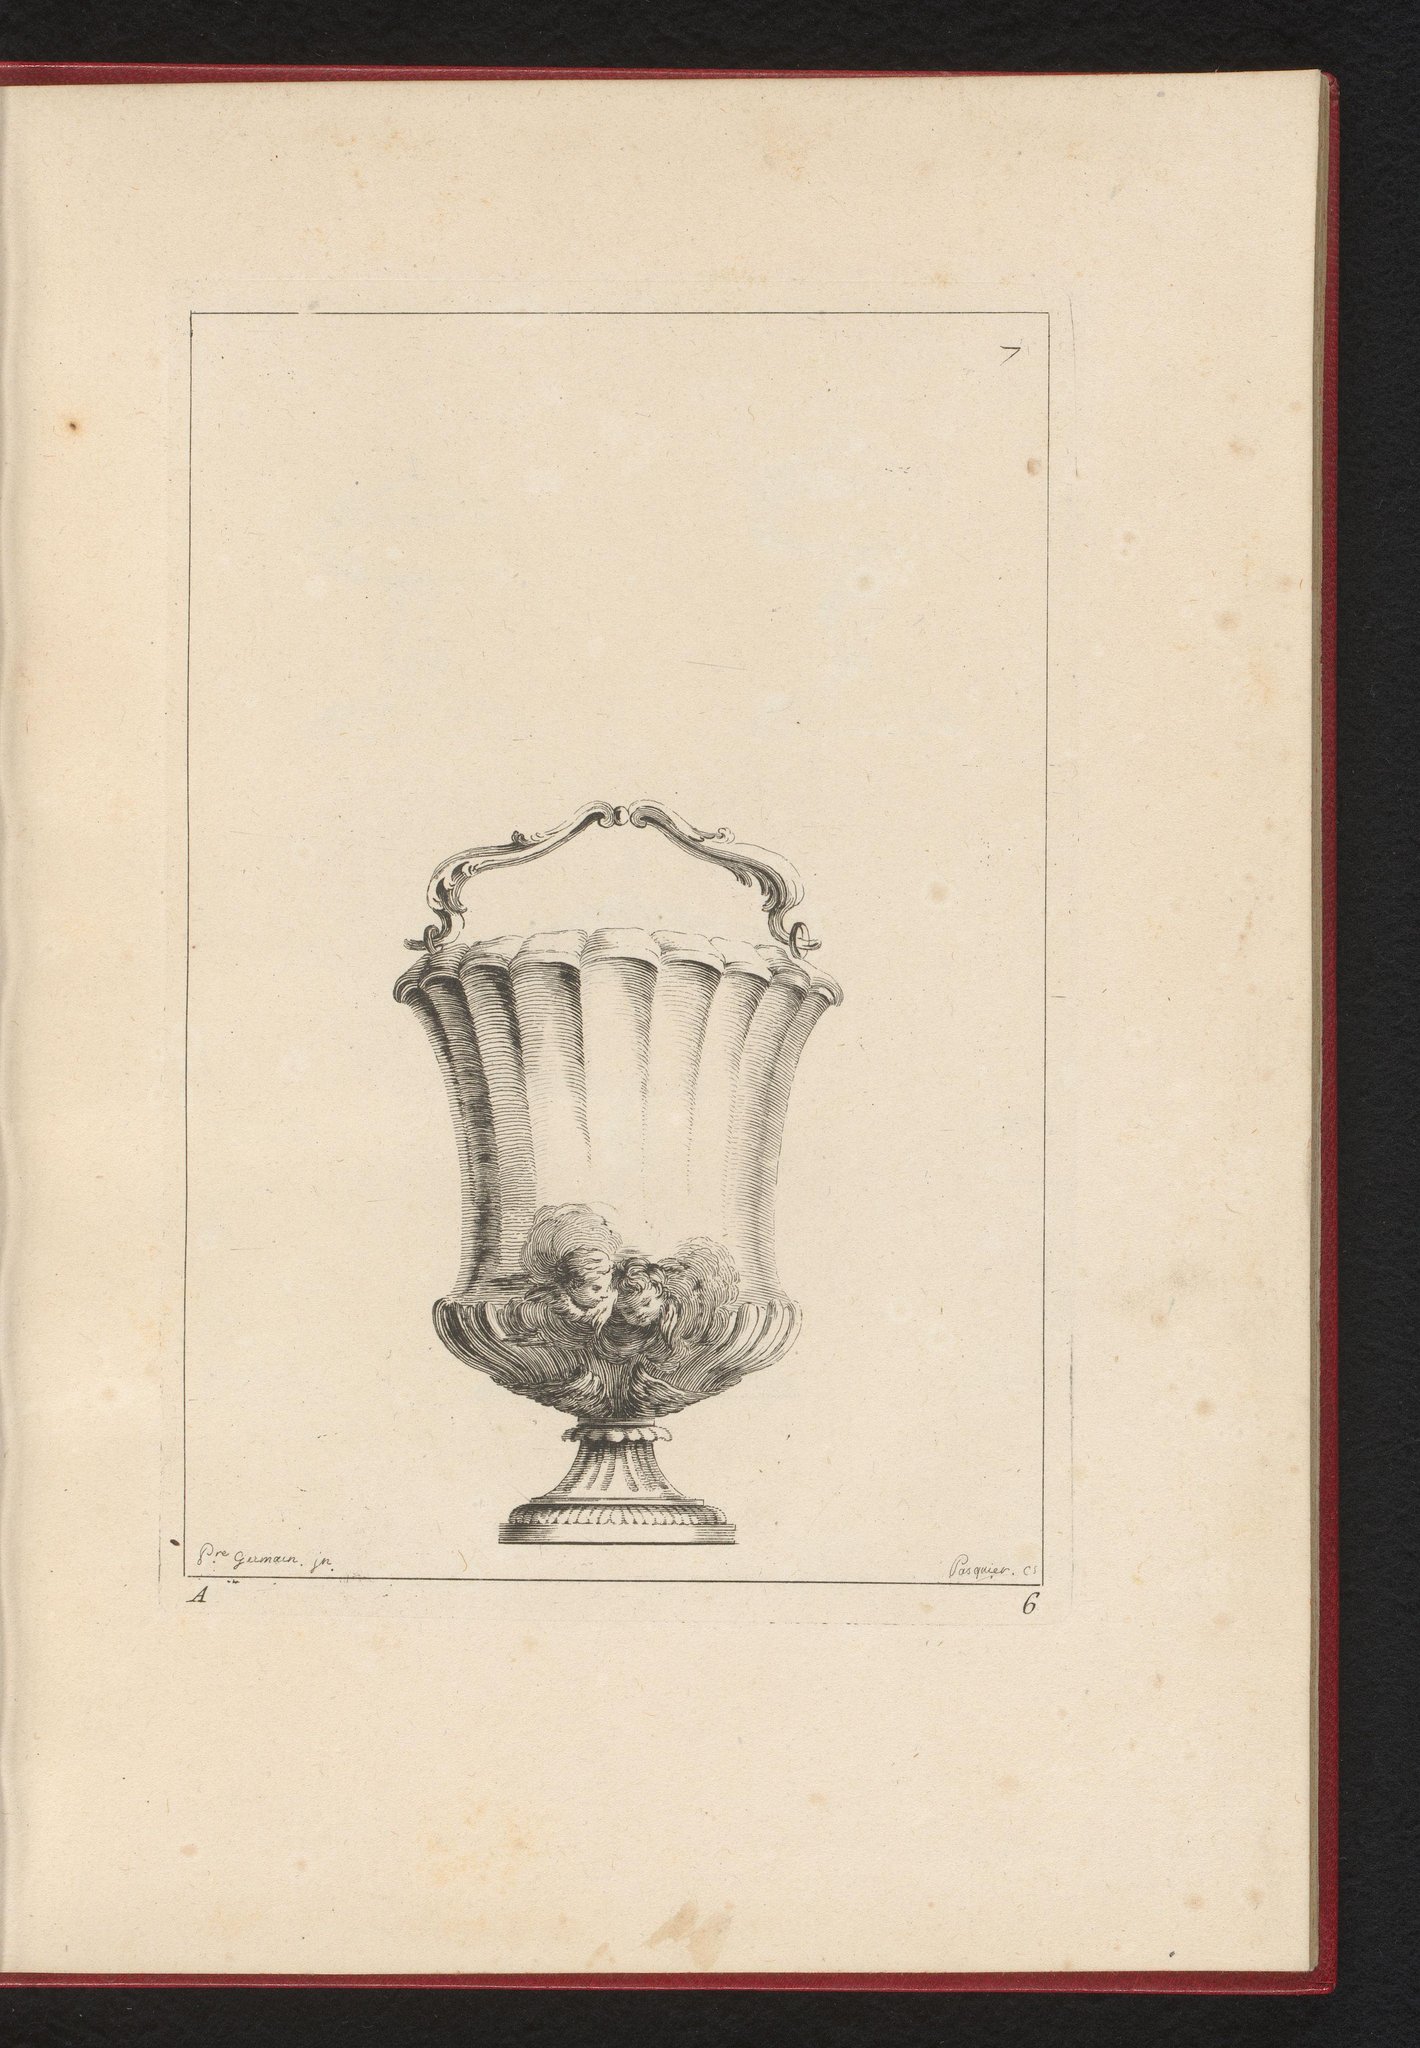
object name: print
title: Elements d'orfevrerie divisés en deux parties de cinquante feuilles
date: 1748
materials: paper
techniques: etching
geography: paris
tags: ornaments ~ art, vessels and utensils used in the church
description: Een aantal van de objecten in deze reeks heeft een eigen ondertitel, die verwijst naar genummerde 'cahiers' (afleveringen) waarin de prenten werden uitgegeven. Het is onduidelijk welke objecten recies bij welke aflevering horen. Daarom is die ondertitel enkel verwerkt bij de prent waarop die voorkomt.